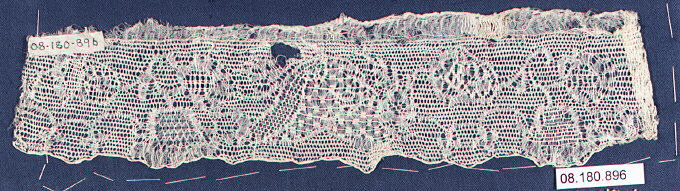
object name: fragment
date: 1701-1800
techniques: embroidery